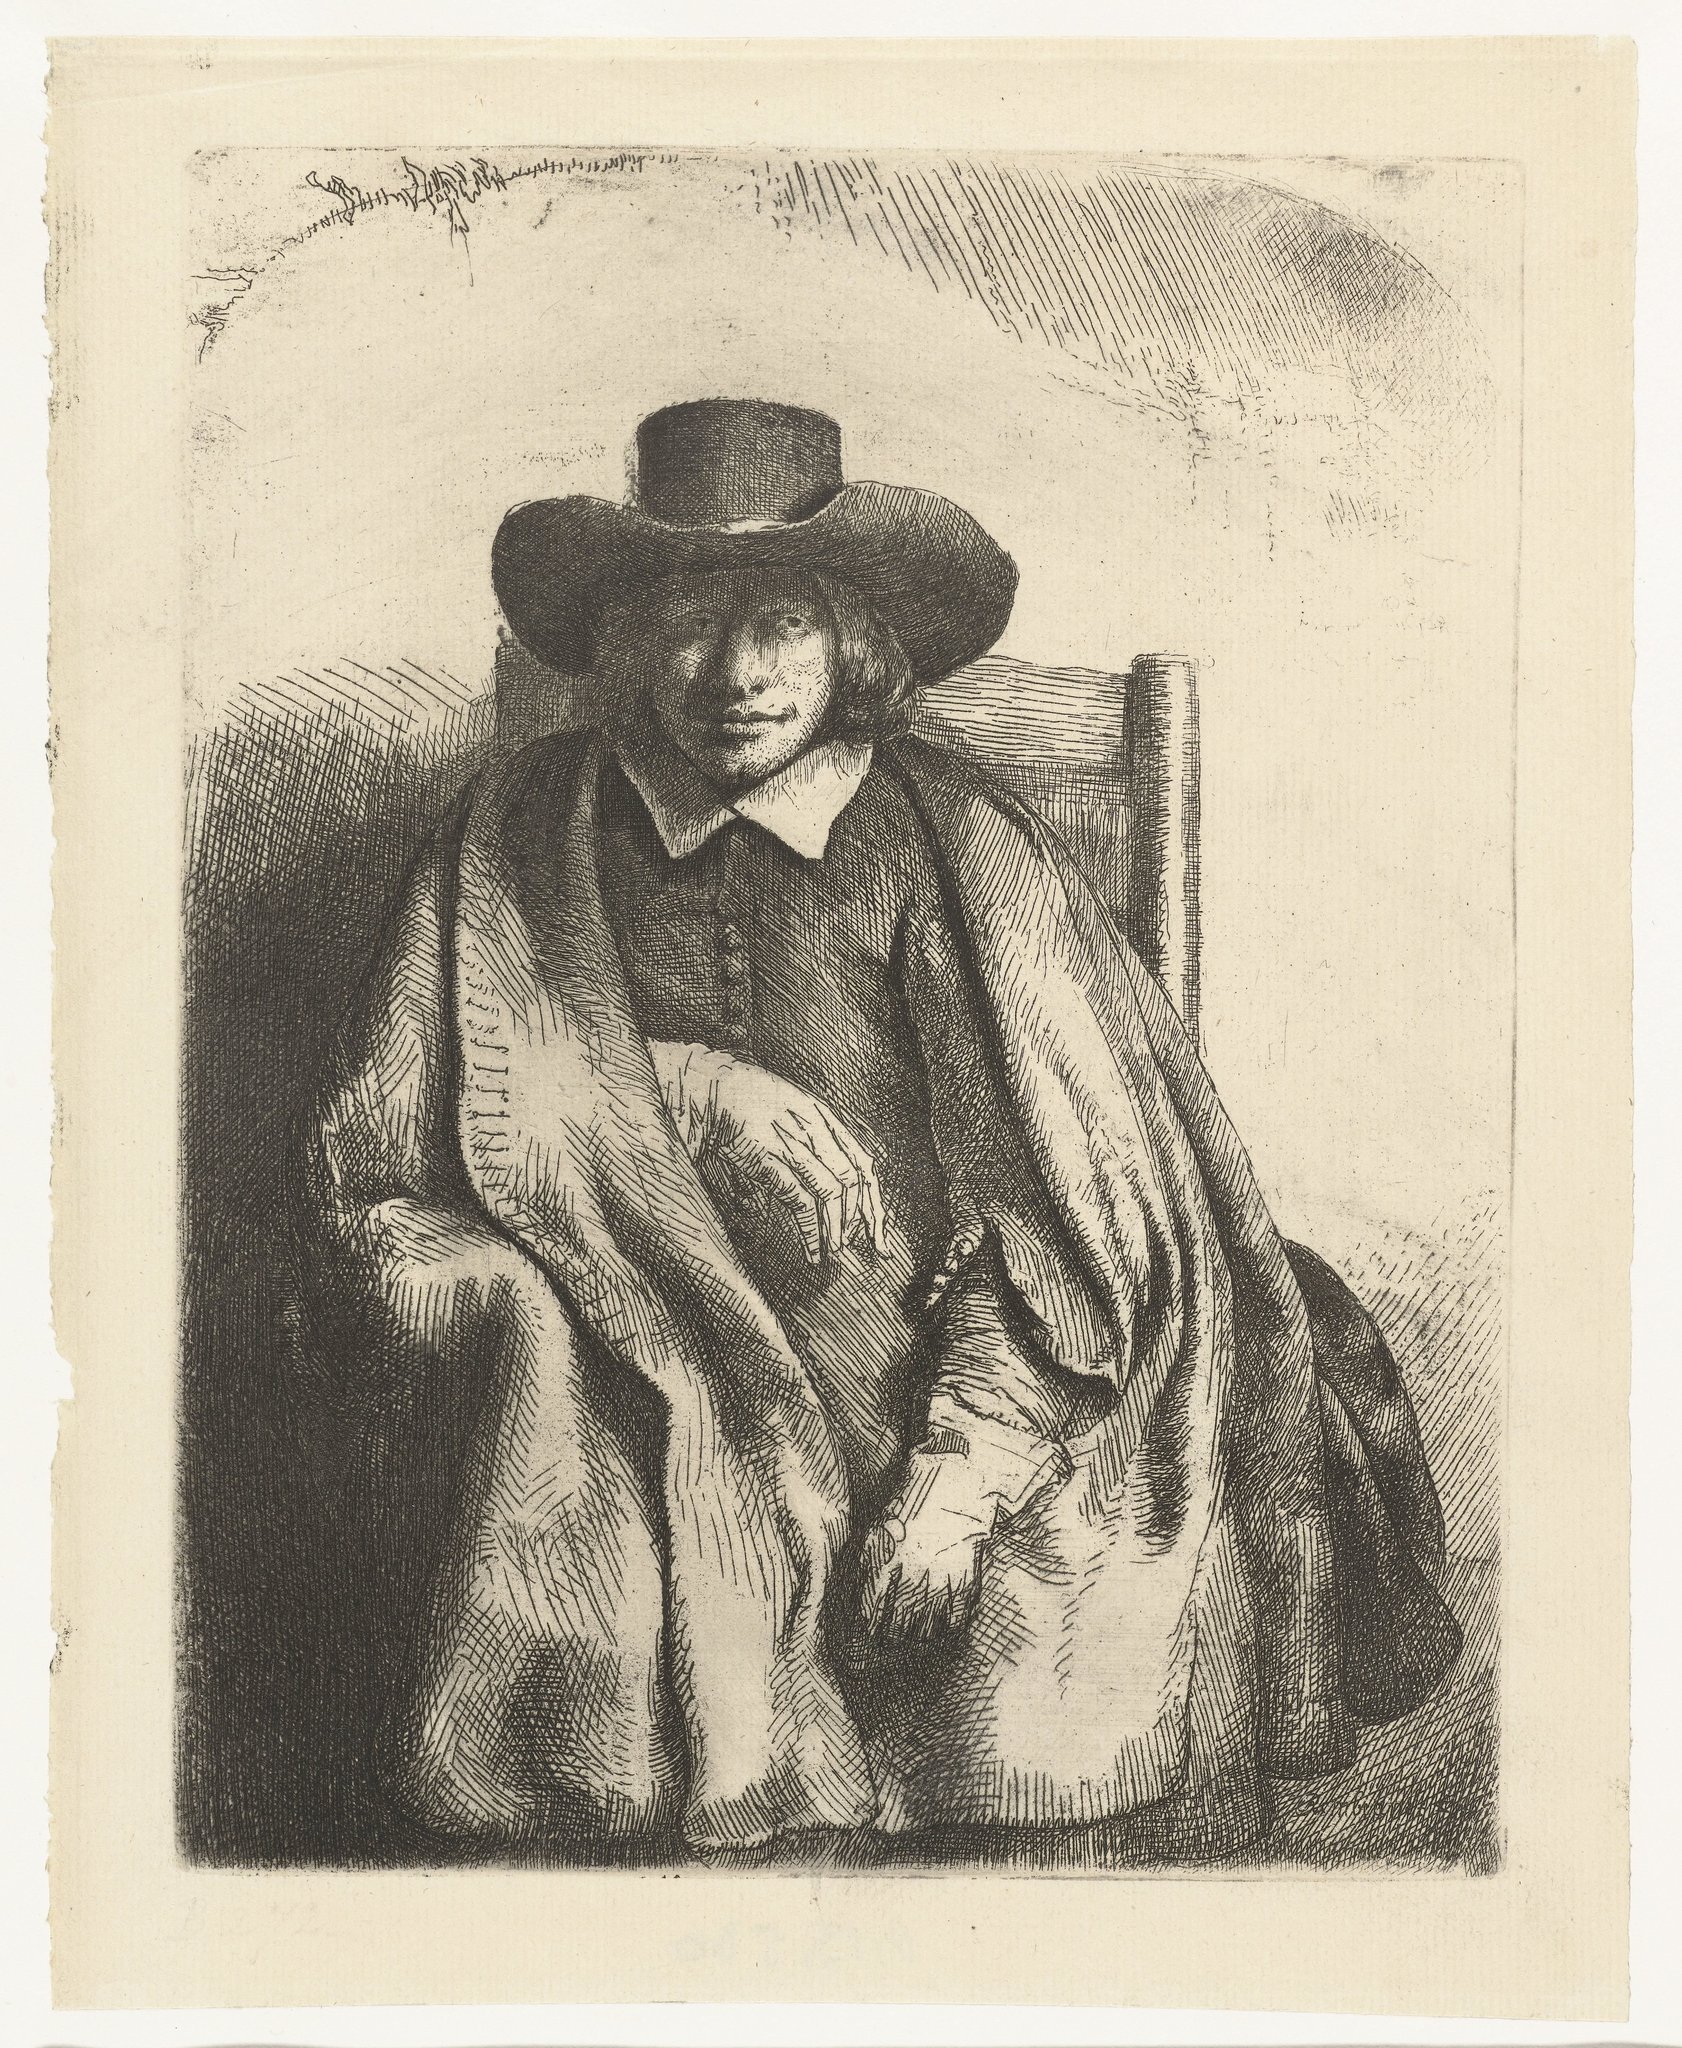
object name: print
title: Clement de Jonghe, printseller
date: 1651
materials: paper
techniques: drypoint, etching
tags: germany, amsterdam, print maker, publisher, clement de jonghe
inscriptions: inscription: ‘Coppier’, signature and date: ‘Rembrandt f. 1651’